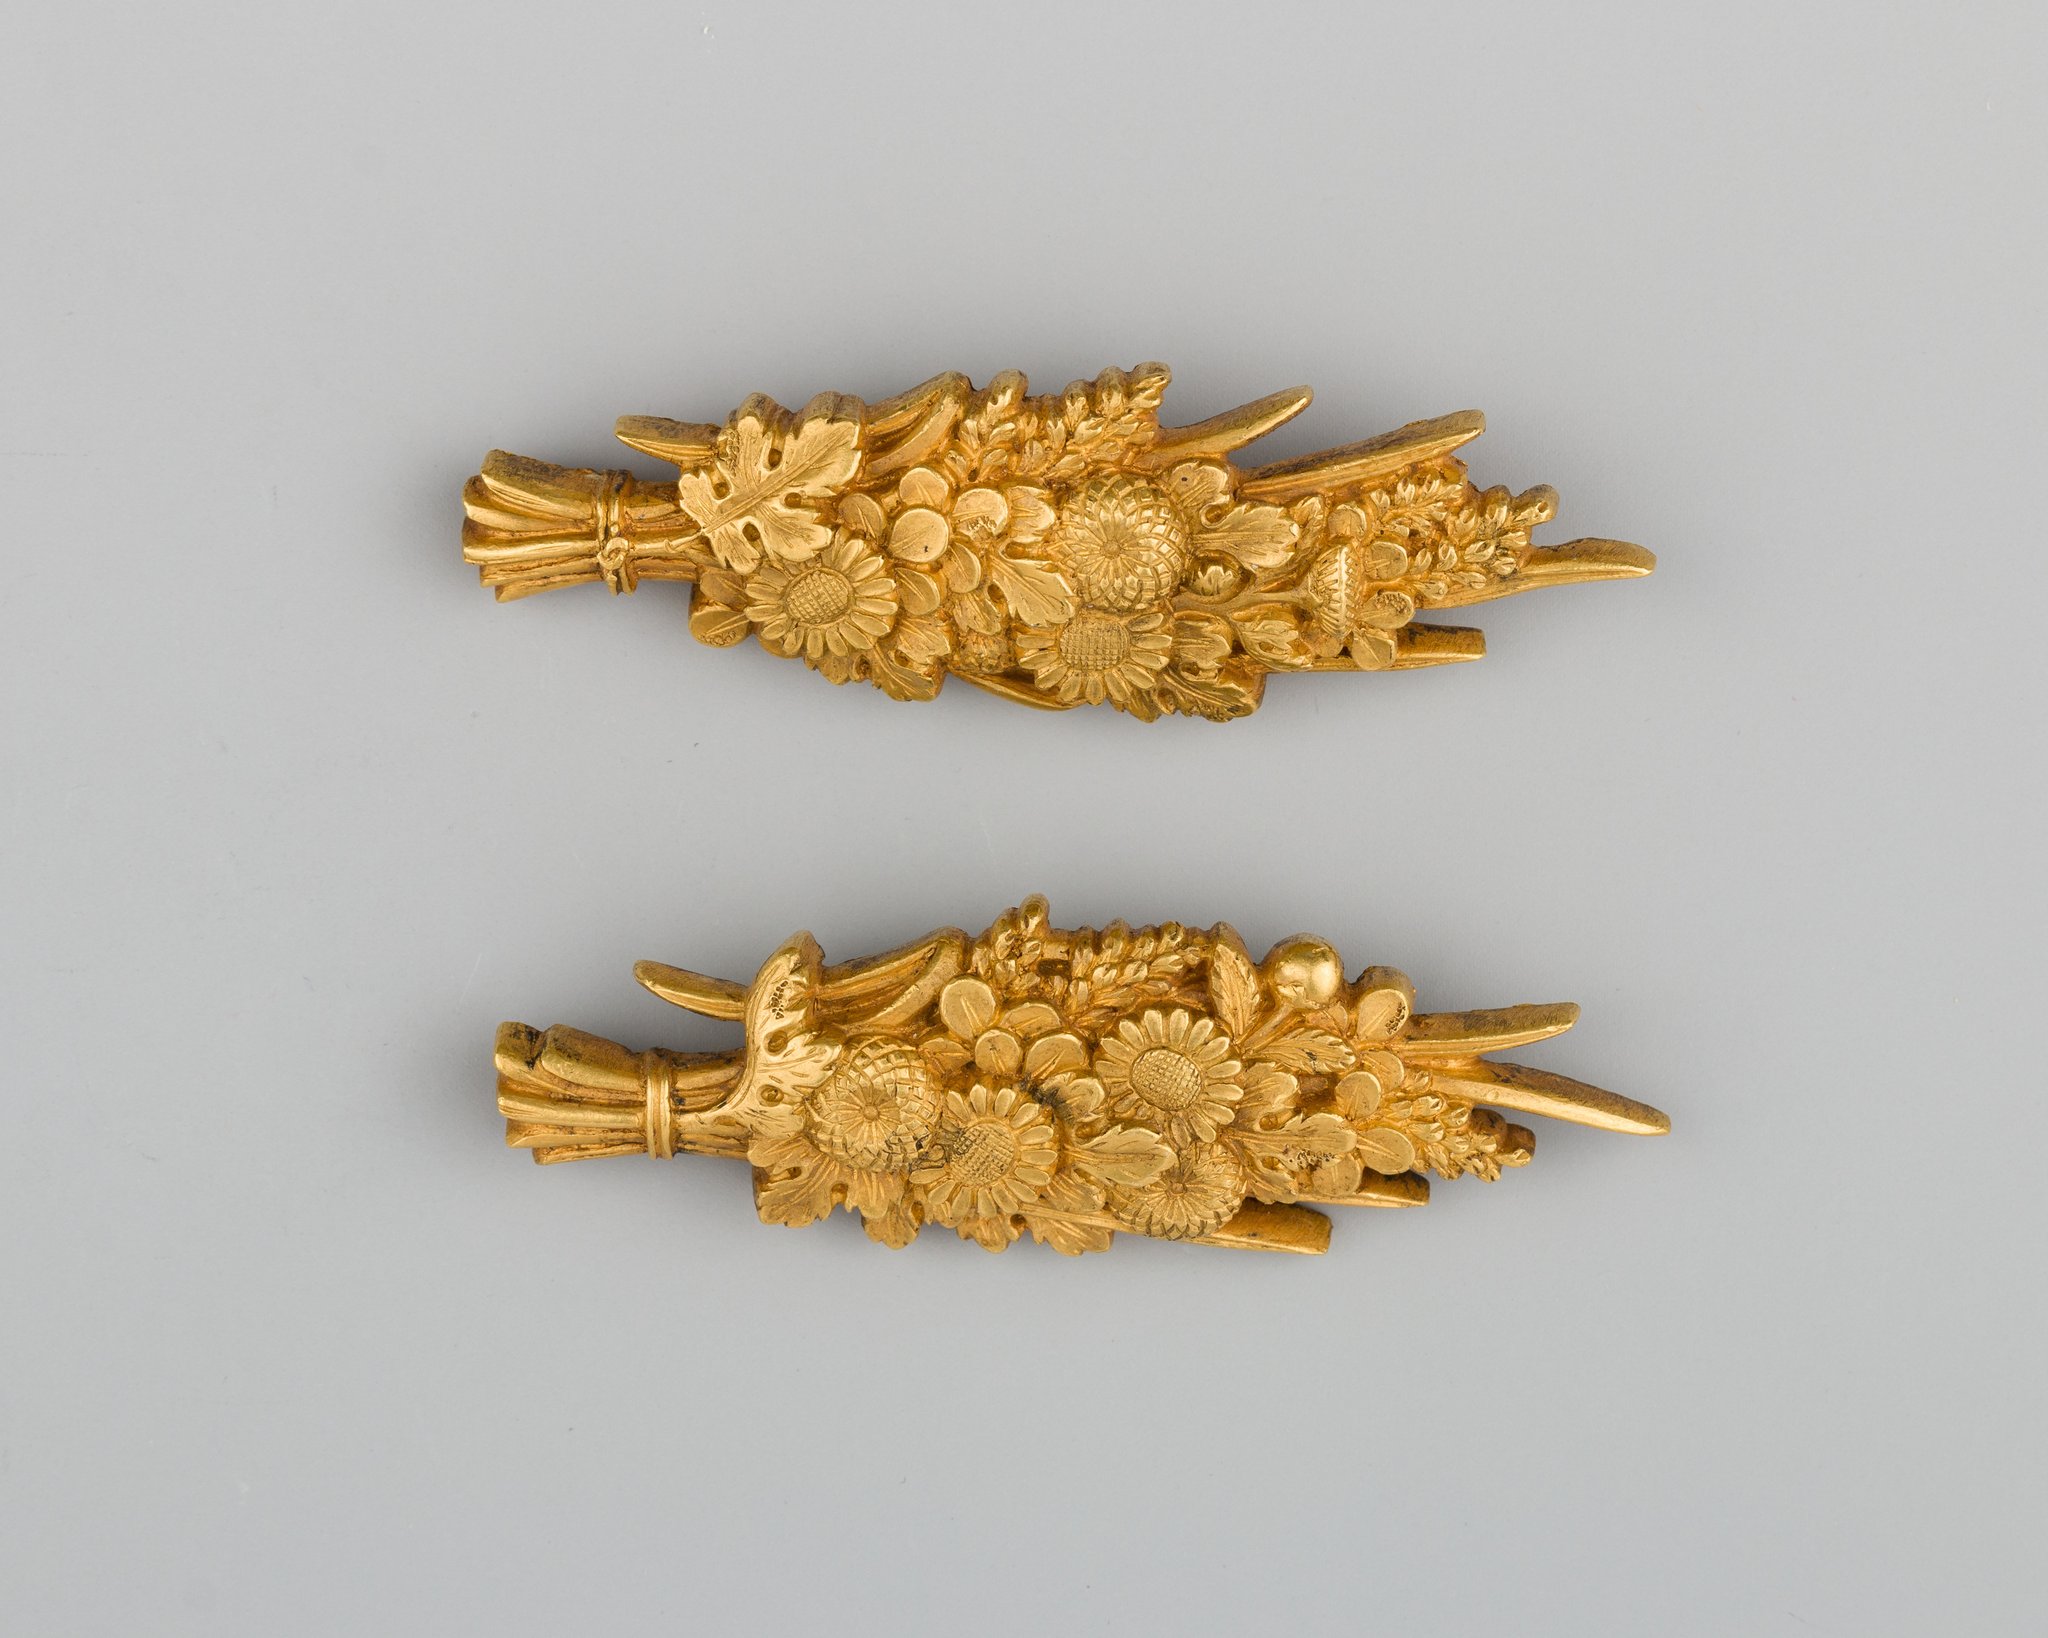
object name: pair of sword grip ornament menuki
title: Pair of Sword-Grip Ornaments (Menuki)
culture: japanese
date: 1701-1800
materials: gold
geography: japan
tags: flowers